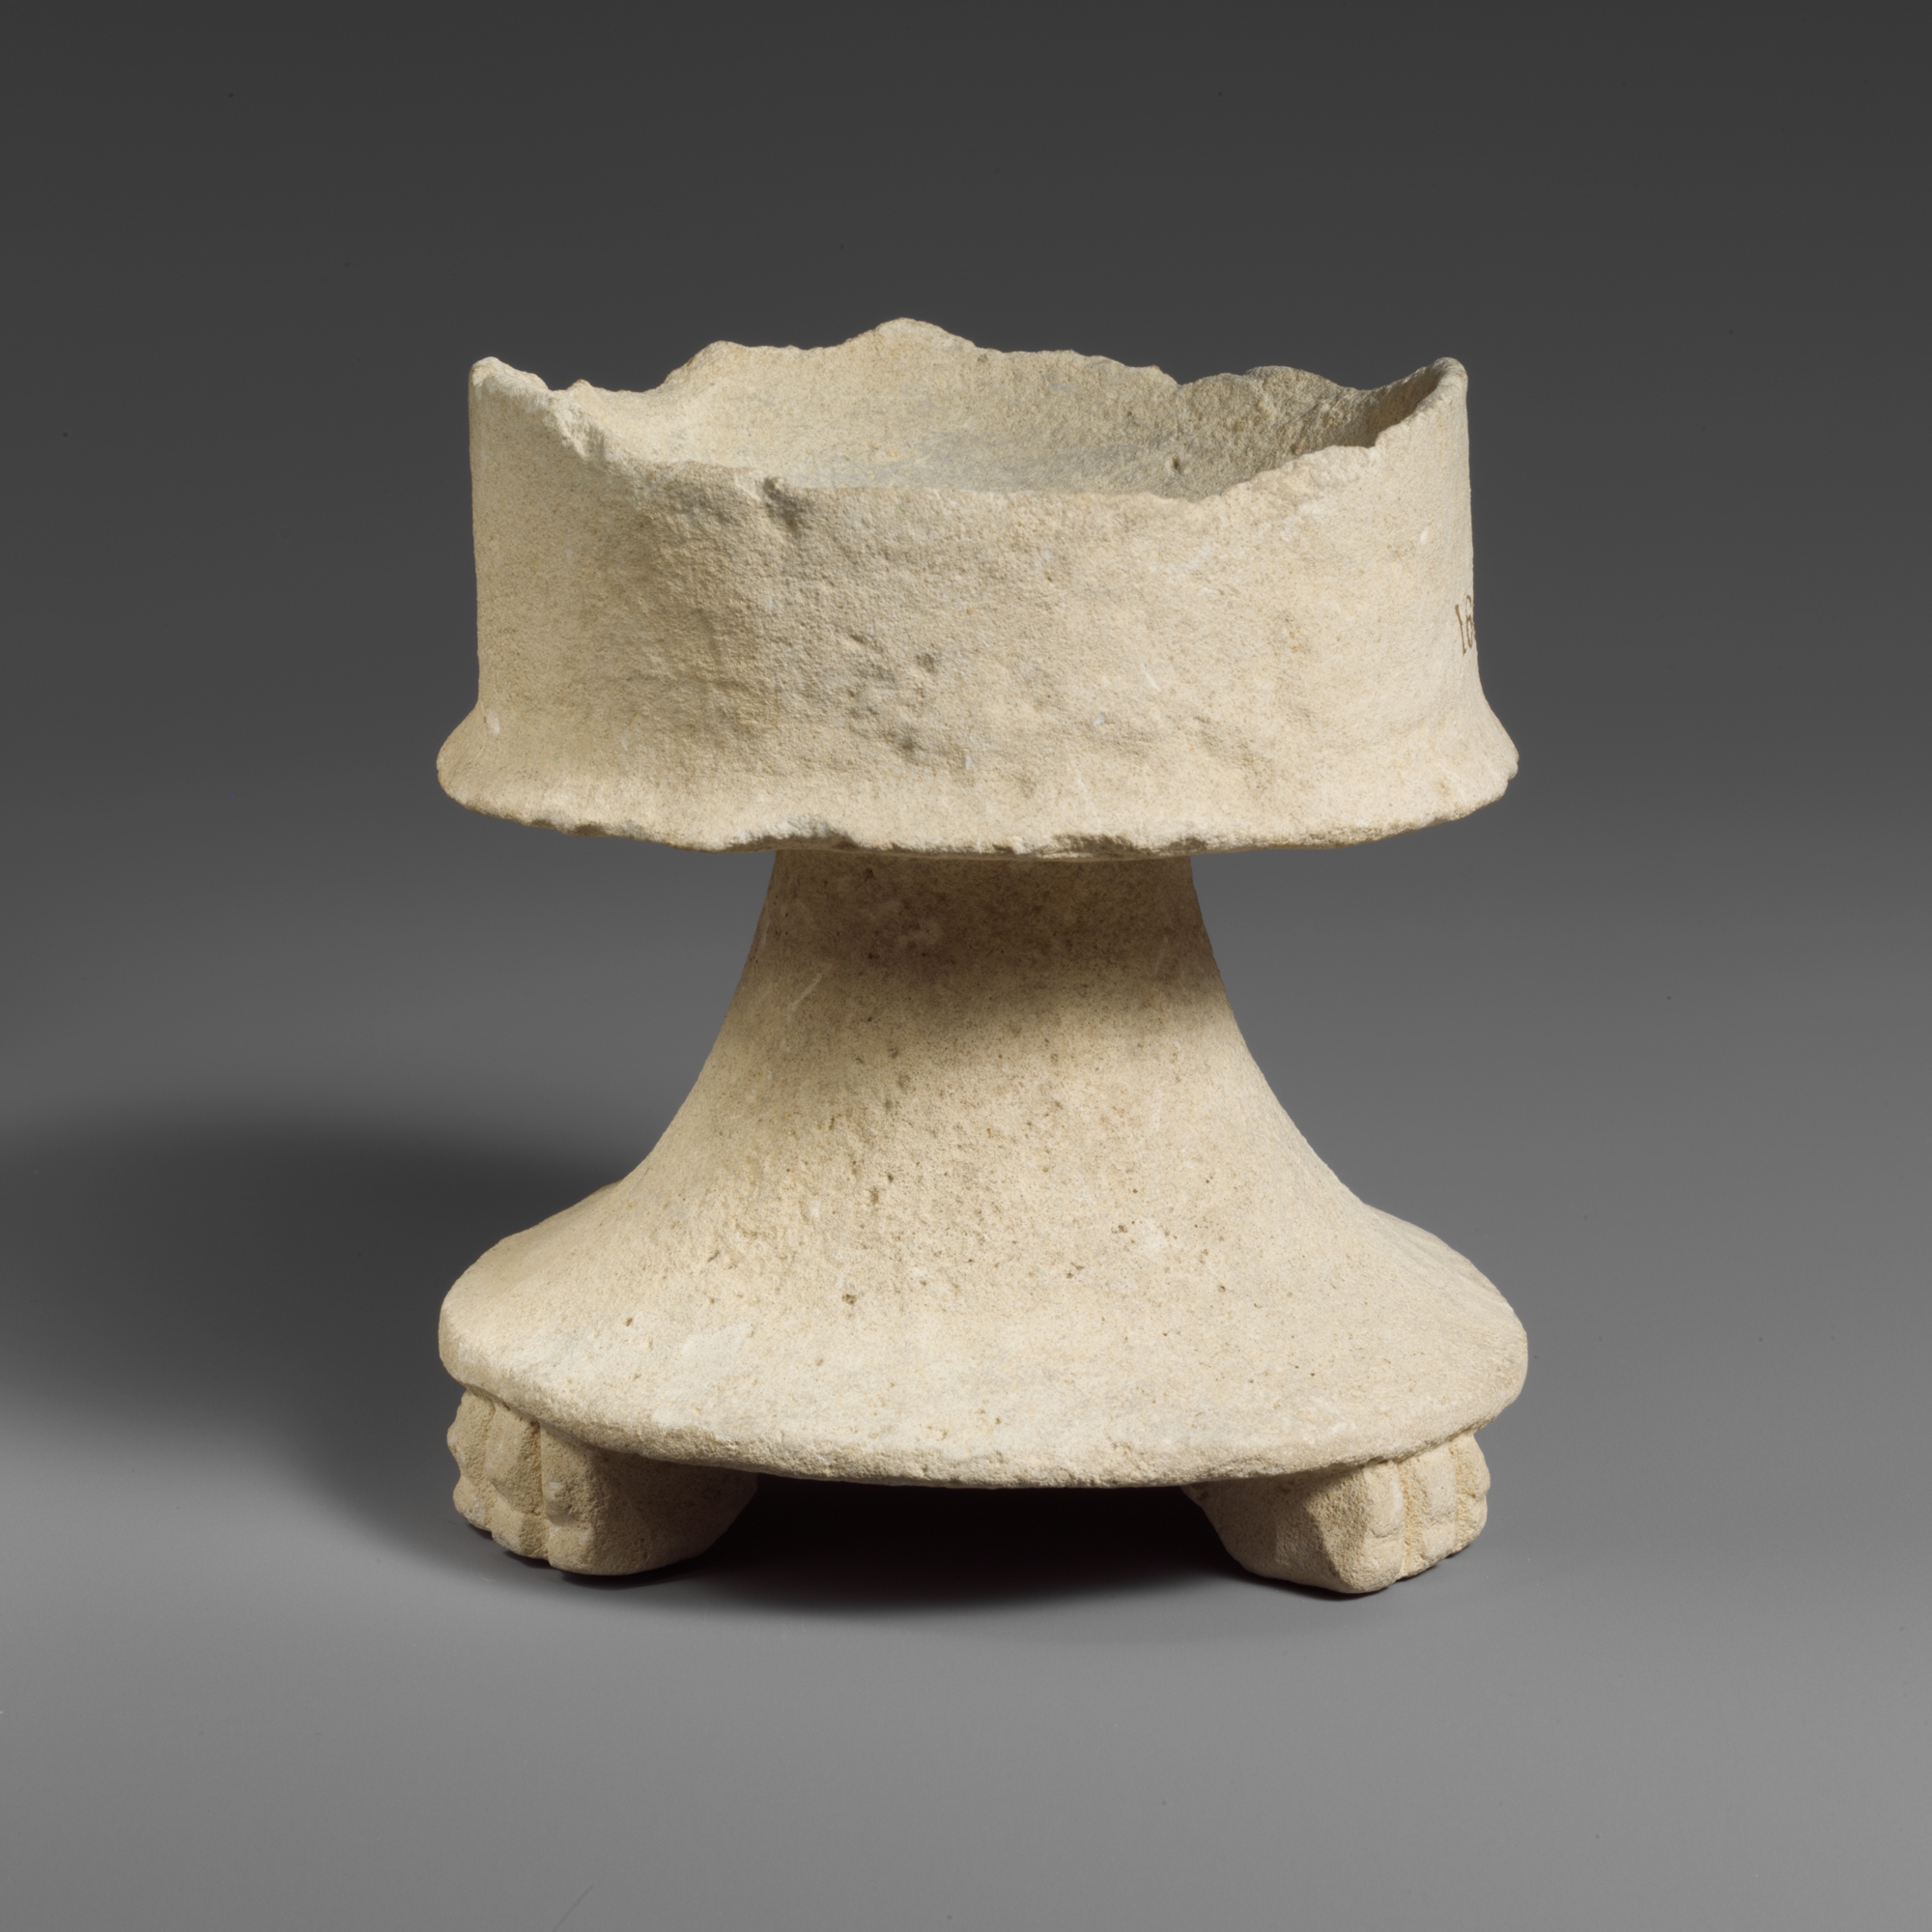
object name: thymiaterion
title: Limestone incense burner on three legs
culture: cypriot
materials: limestone